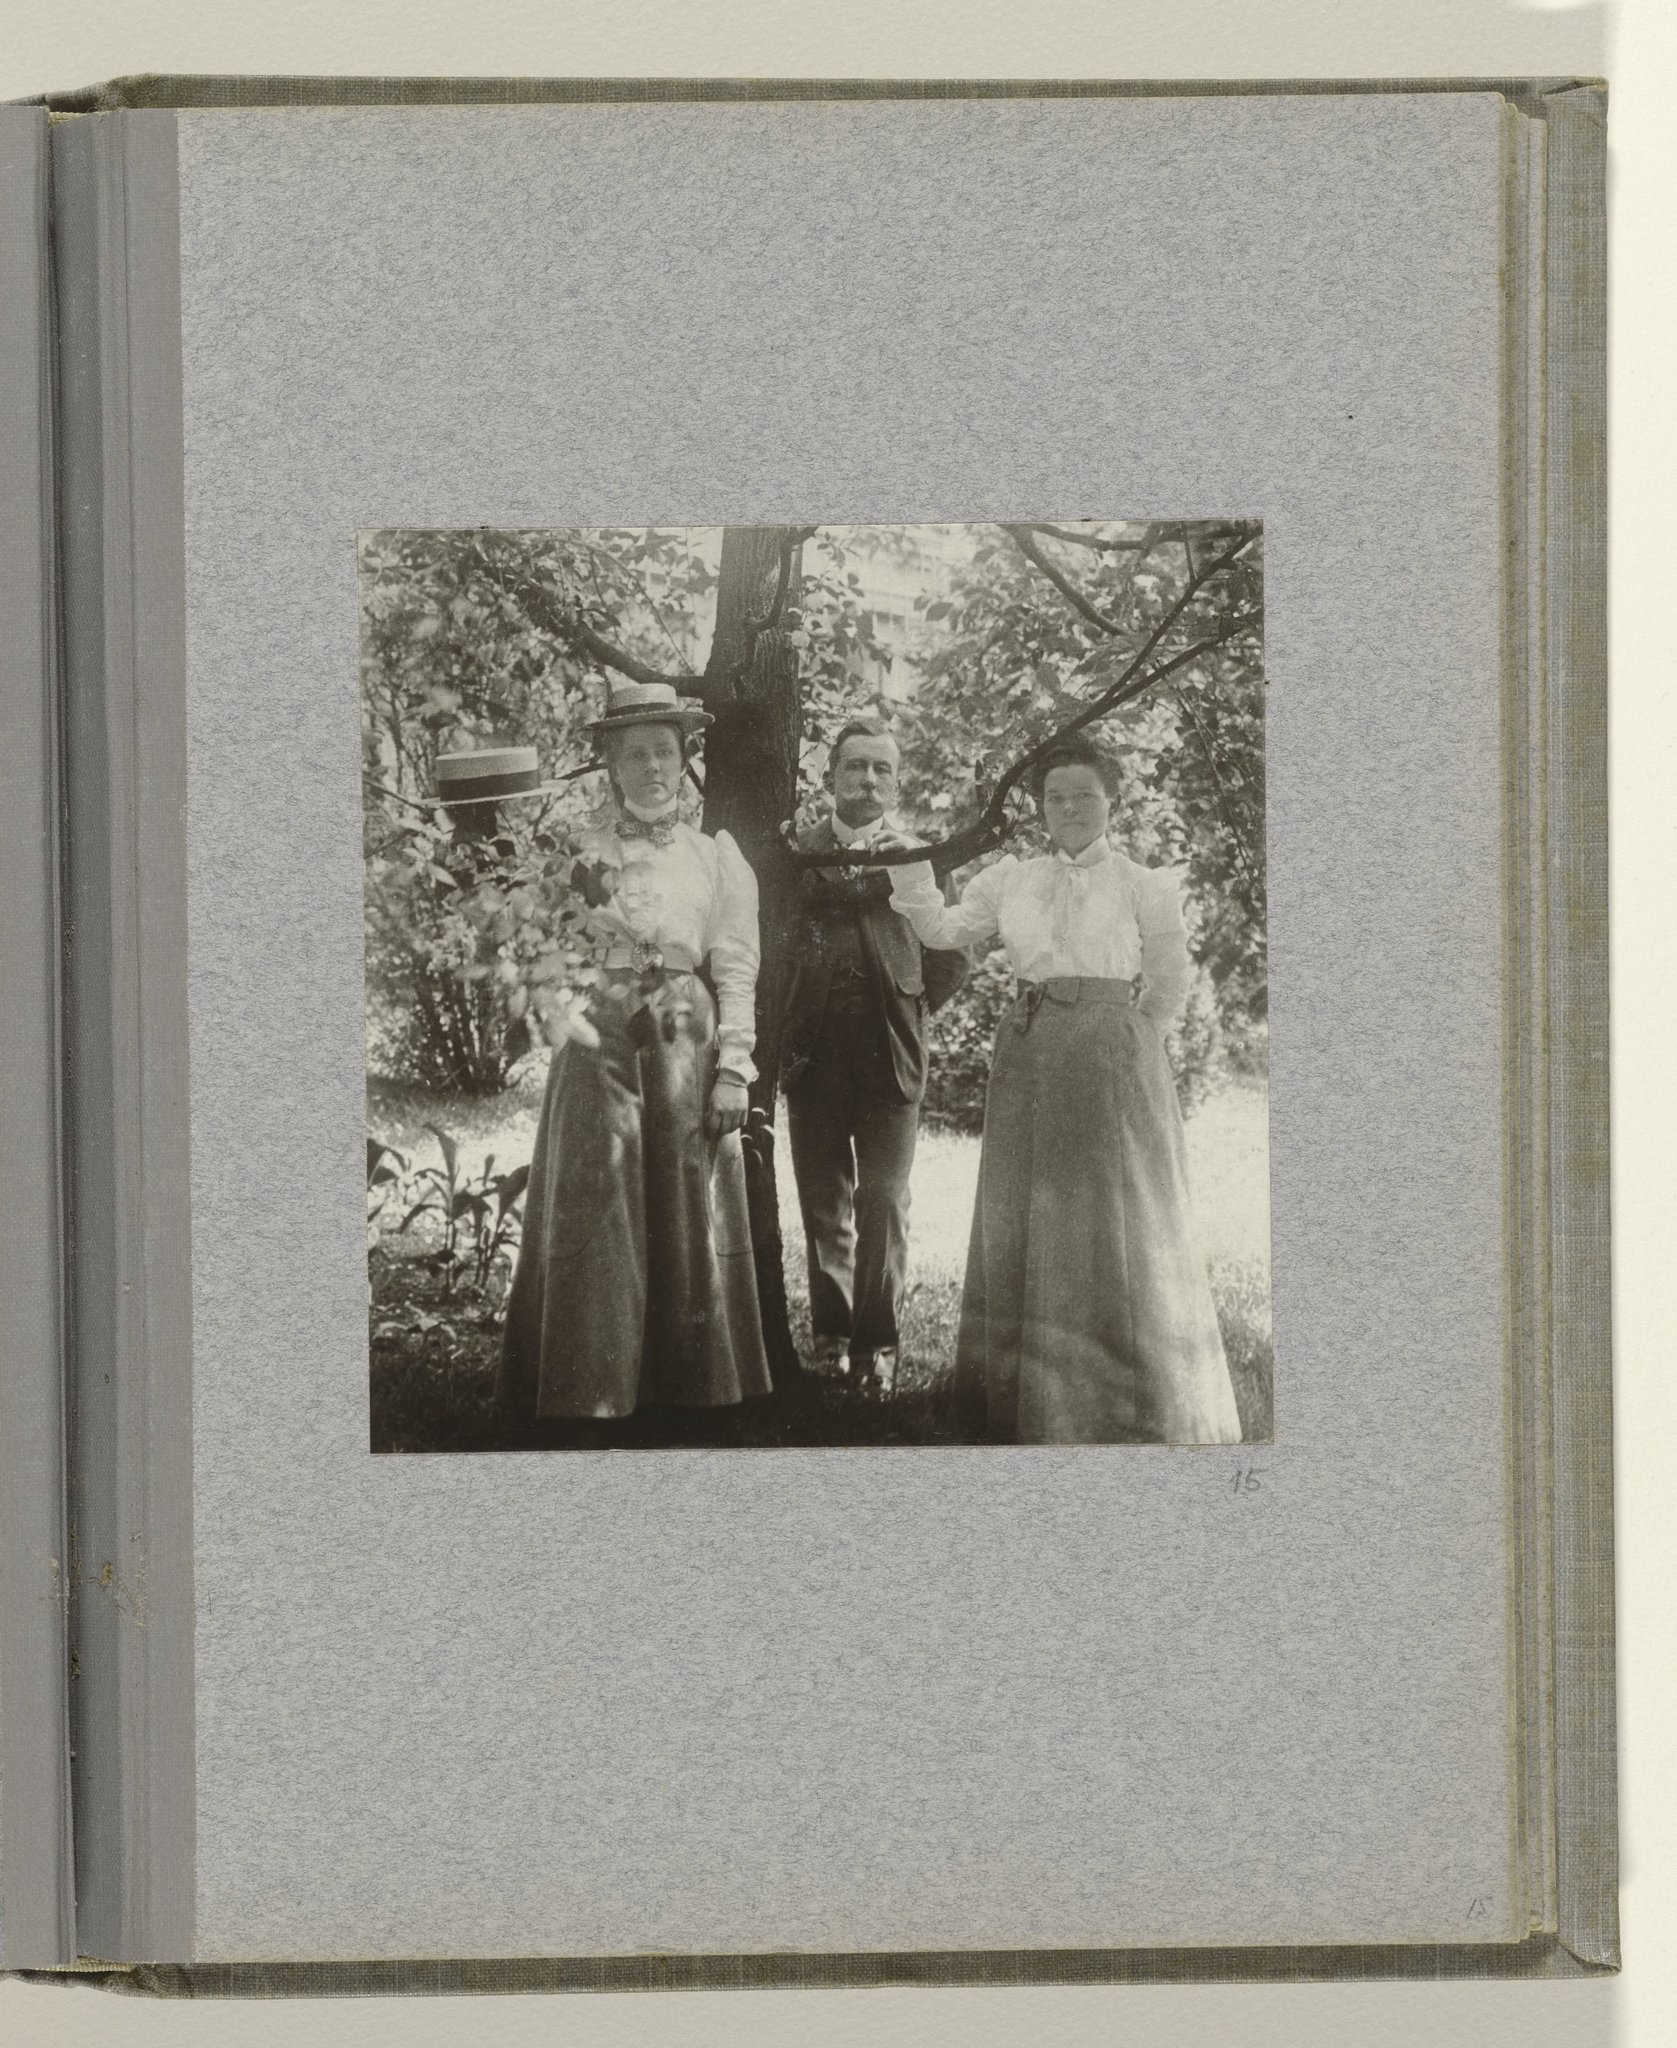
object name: photograph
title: J.B. Aug. Kessler met zelfontspanner, met twee dochters in de tuin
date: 1897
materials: paper, photographic support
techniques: gelatin silver print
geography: netherlands